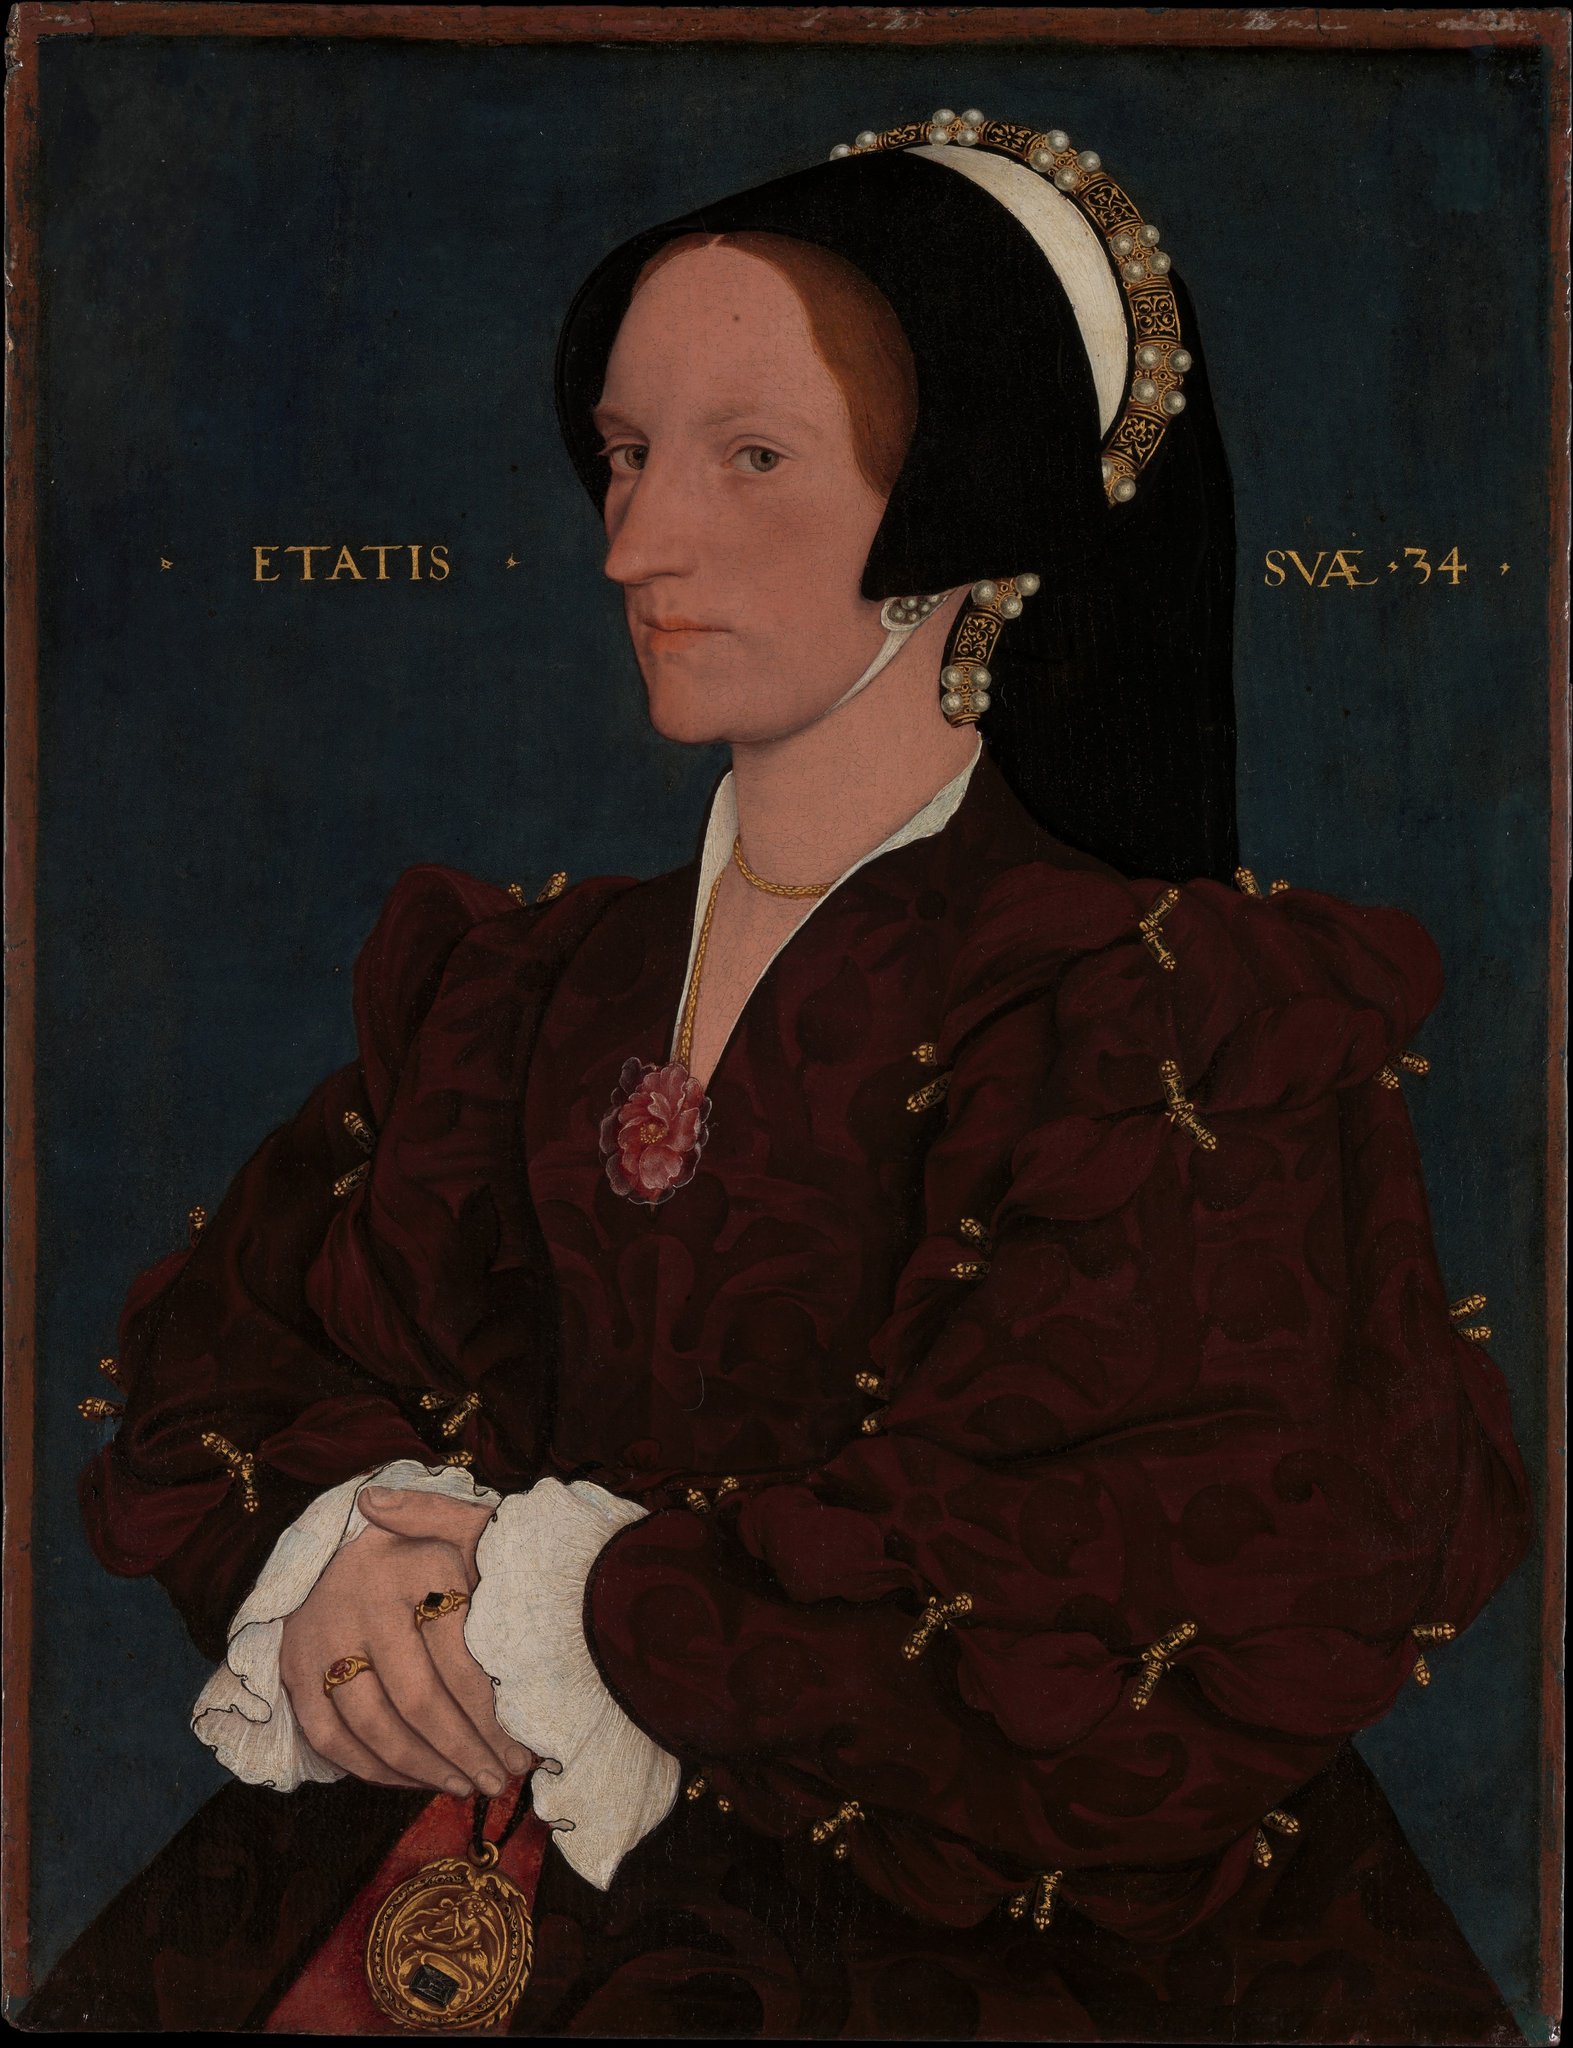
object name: painting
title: Lady Lee (Margaret Wyatt, born about 1509)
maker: hans holbein the younger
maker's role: artist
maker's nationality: german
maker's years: 1497-1543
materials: gold, wood, oil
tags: portraits,women